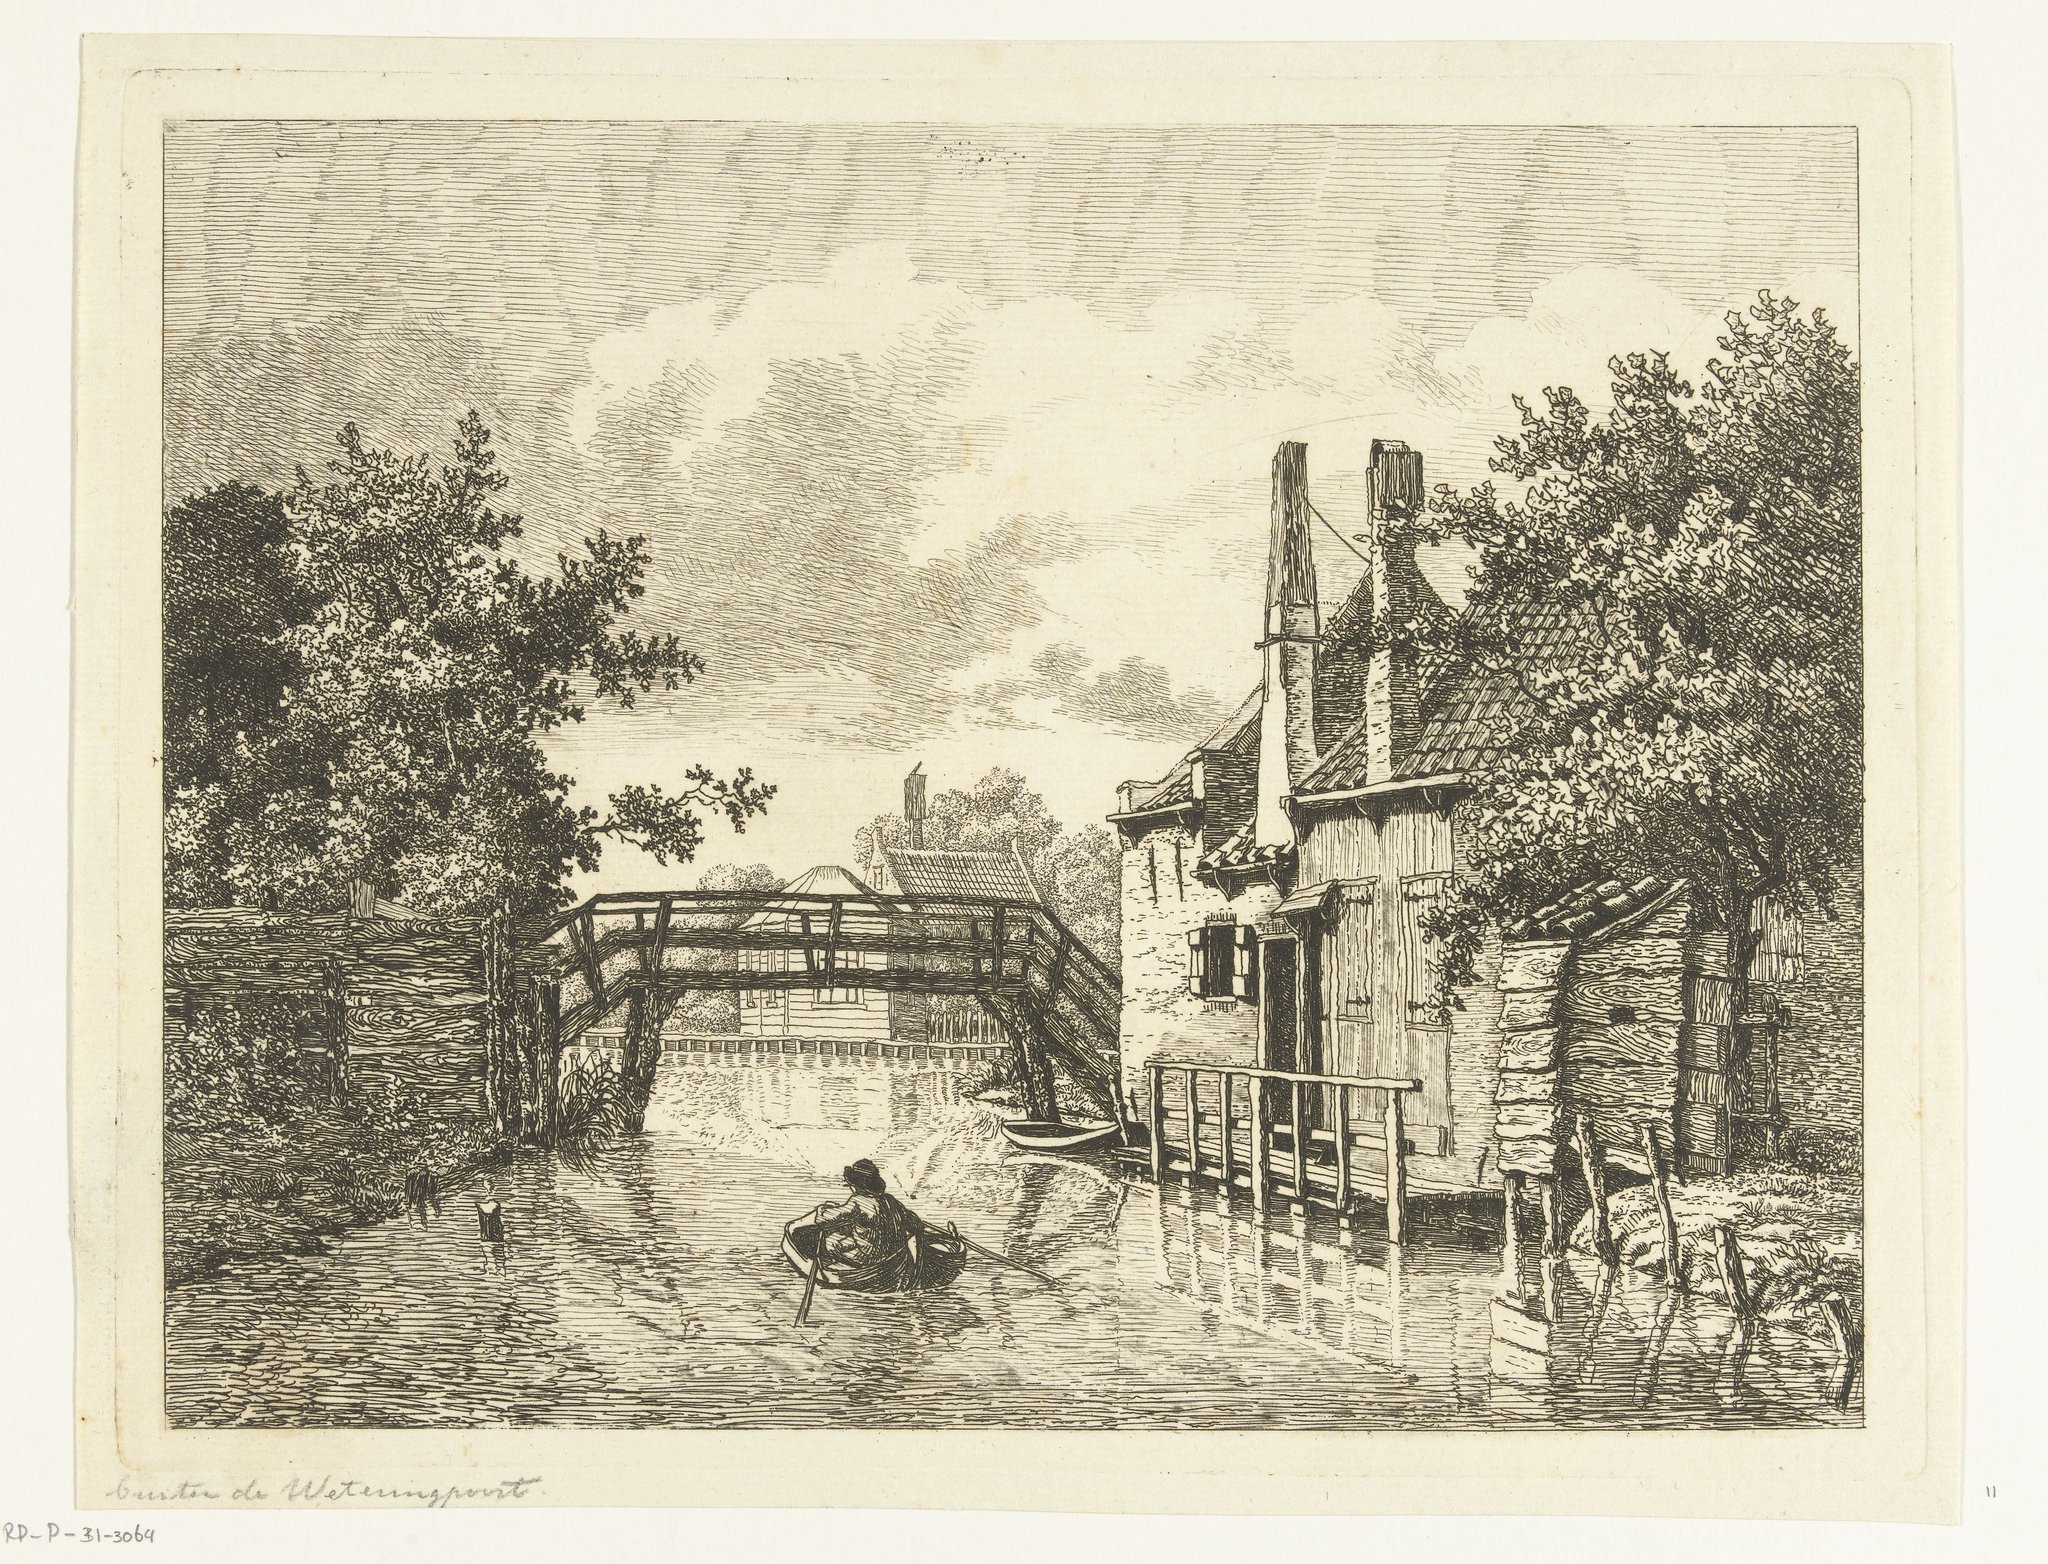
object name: print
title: Man in een roeiboot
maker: anthonie van den bos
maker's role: draughtsman, print maker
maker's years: 1763-1838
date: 1778-1838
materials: paper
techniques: drypoint, etching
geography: netherlands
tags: rowing-boat, canoe, etc. (+ one person ~ traffic and transport)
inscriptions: collector's mark: Lugt 2228